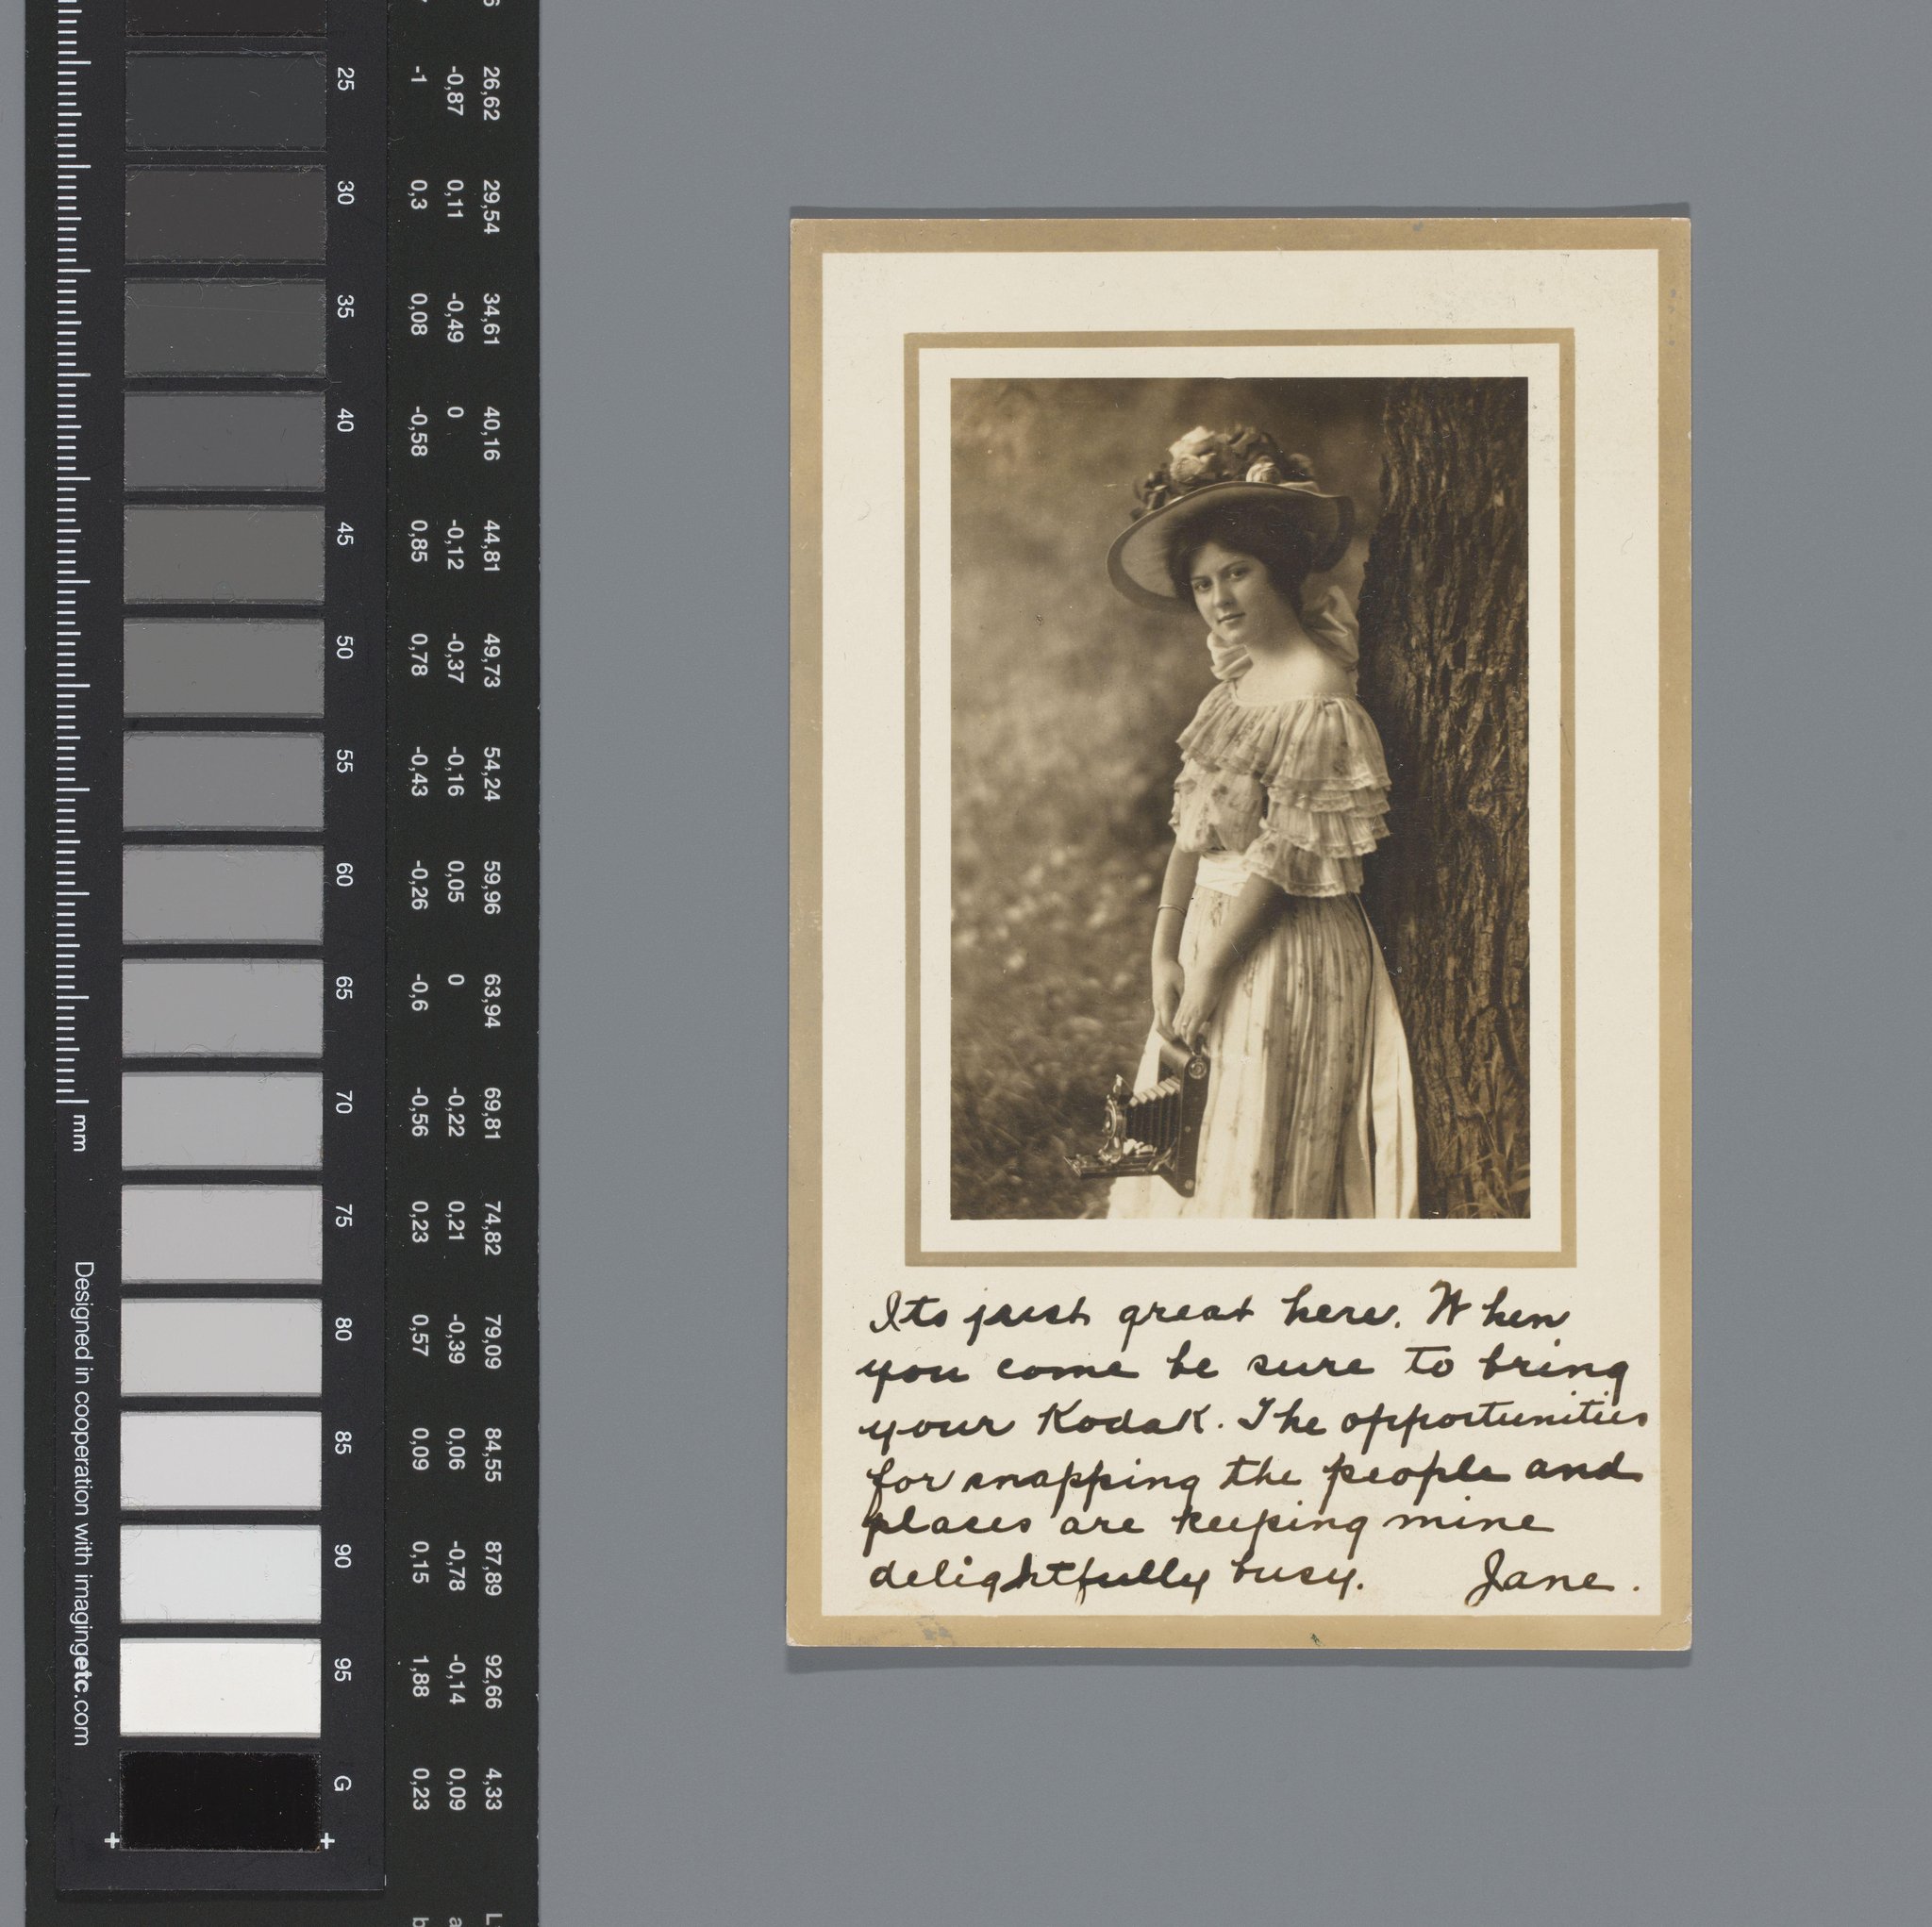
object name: ansichtkaart, prentbriefkaart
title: Reclame voor Kodak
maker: Anonymous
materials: photographic support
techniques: gelatin silver print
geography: united states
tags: publisher, manufacturer, united states of america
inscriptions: inscription, stamp: ‘1909’, inscription: ‘Its just great here. When you come be sure to bring your Kodak. The opportunities for snapping the people and places are keeping mine delightfully busy. Jane.’